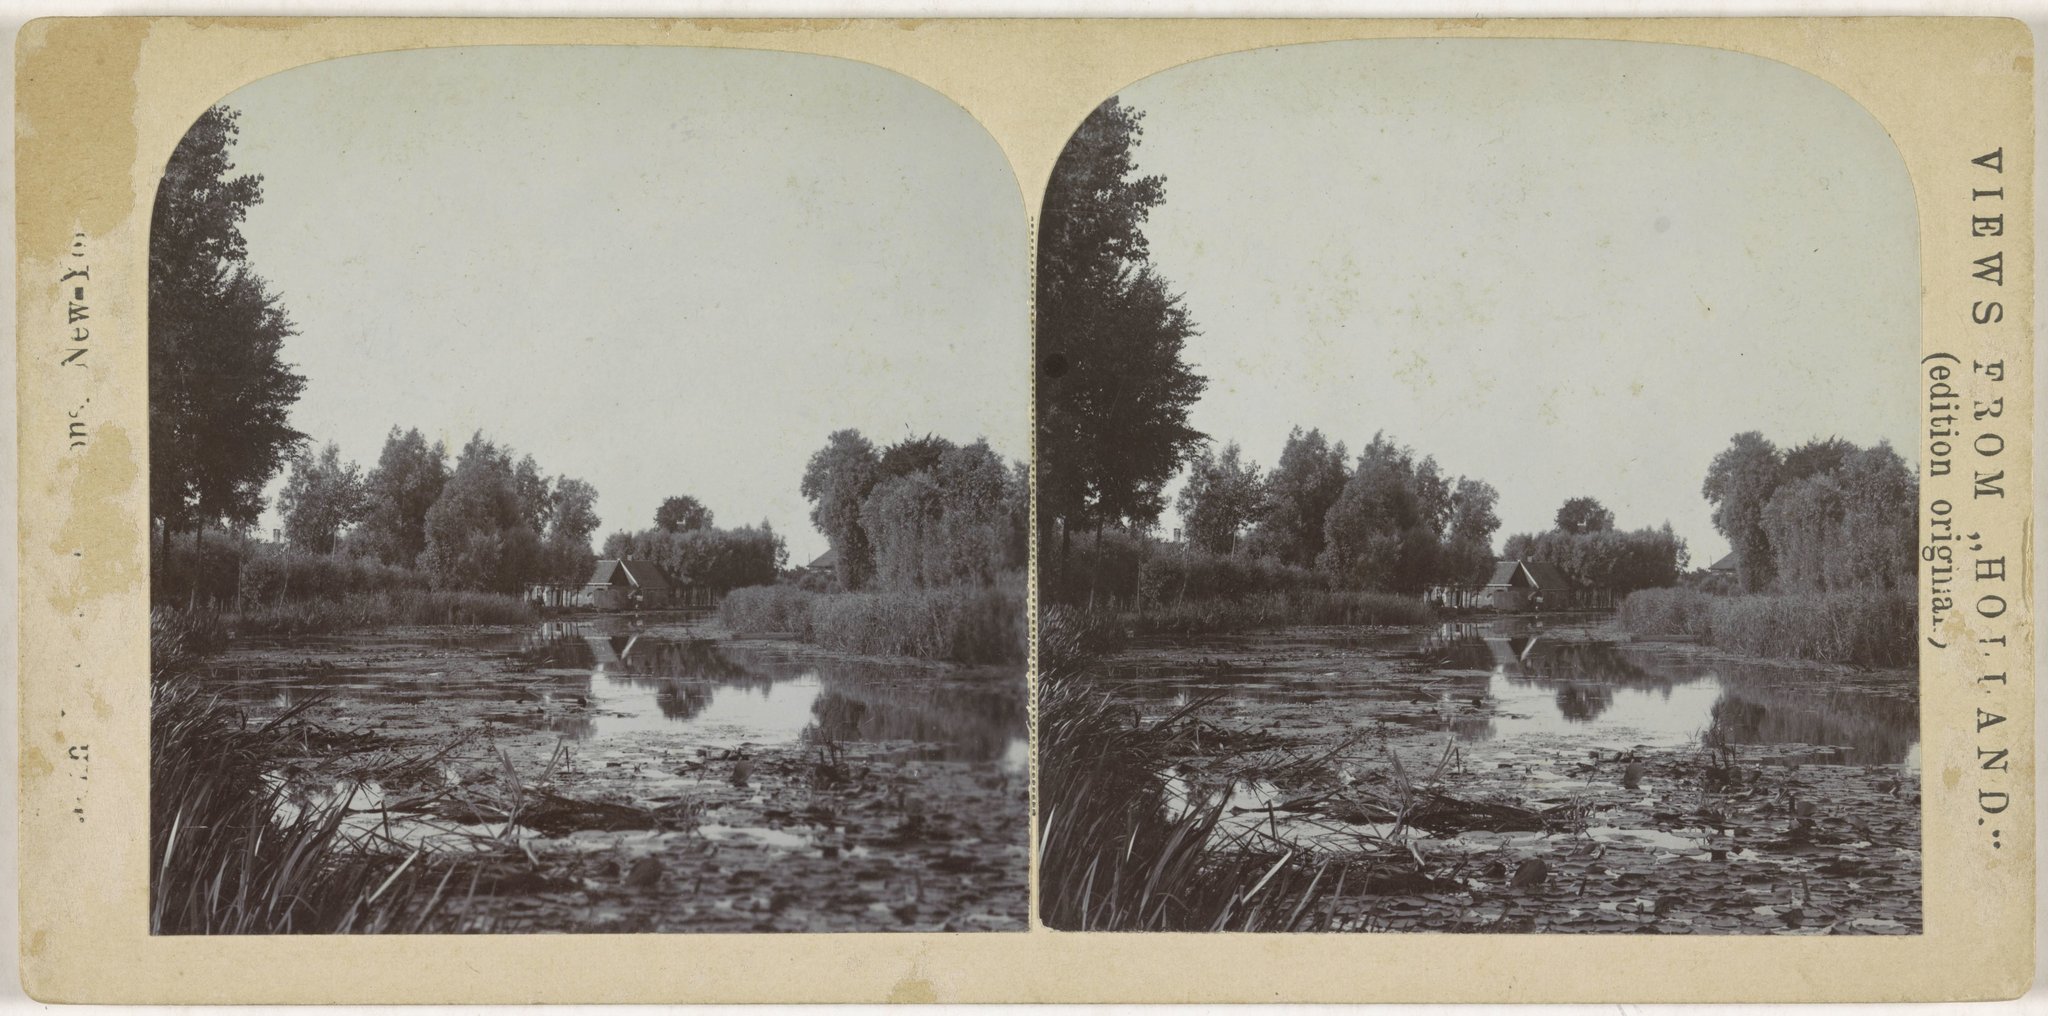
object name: stereograph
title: Gezicht op het Gein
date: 1880-1920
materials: cardboard, paper, photographic support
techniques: gelatin silver print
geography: new york city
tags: netherlands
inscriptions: inscription: ‘VIEWS FROM ''HOLLAND'' (edition original.)’, number: ‘in het Gein’